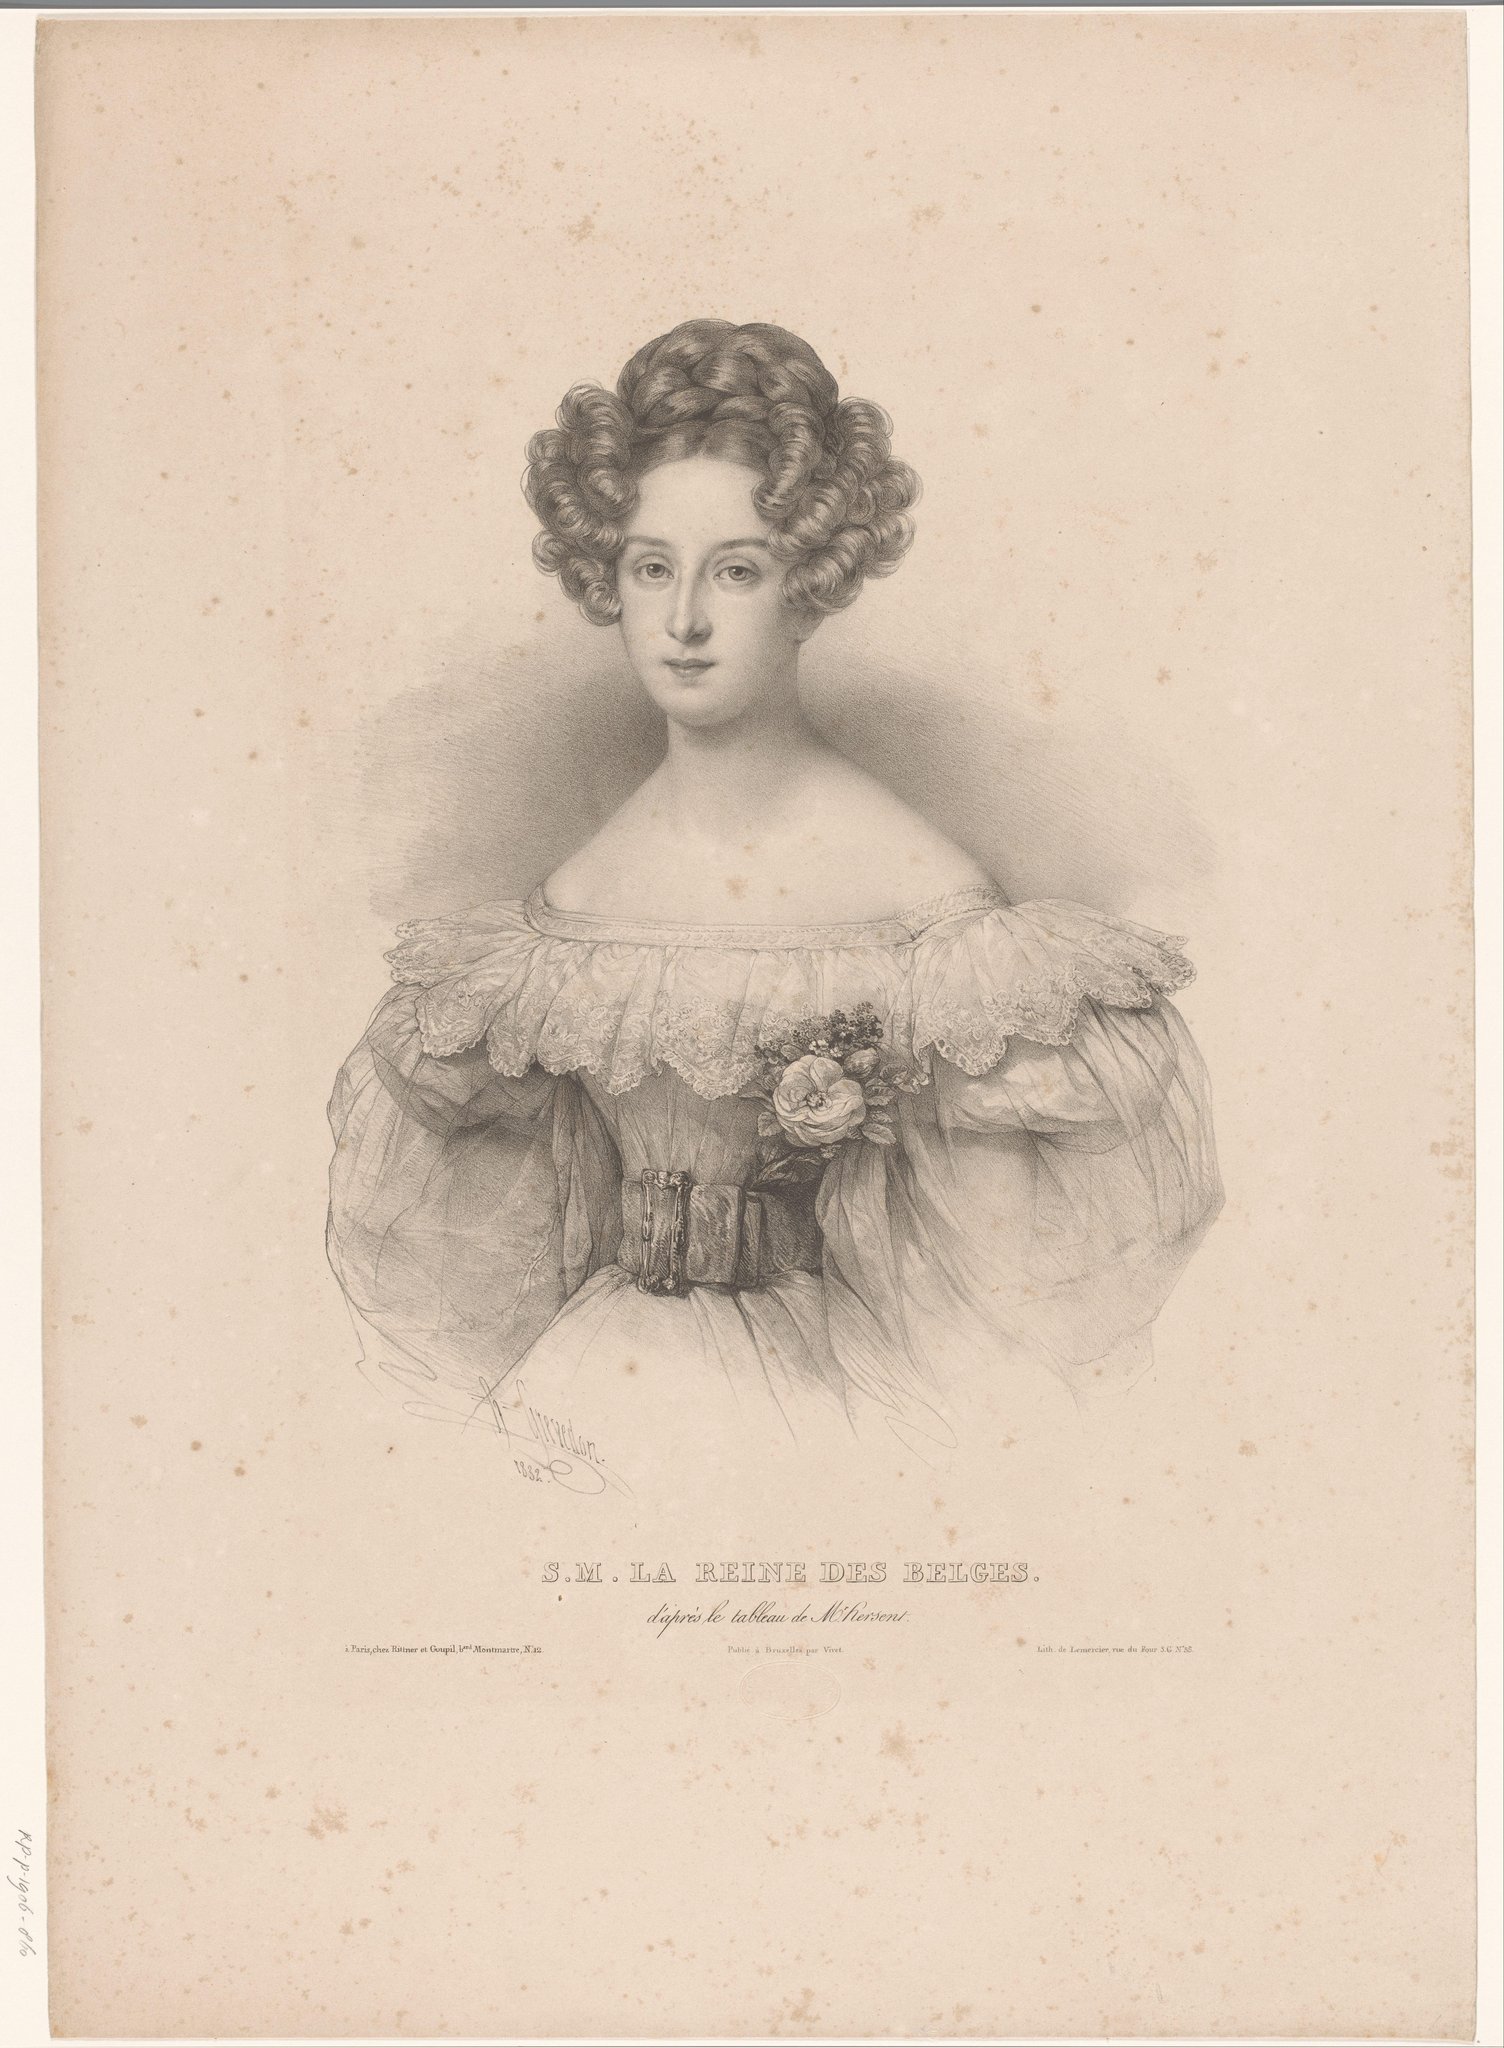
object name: print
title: S.M. la Reine des Belges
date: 1832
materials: paper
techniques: lithograph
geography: paris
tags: louise marie van orléans (koningin van belgië), historical persons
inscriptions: collector's mark: Lugt 2228a, check stamp: Lugt 2140